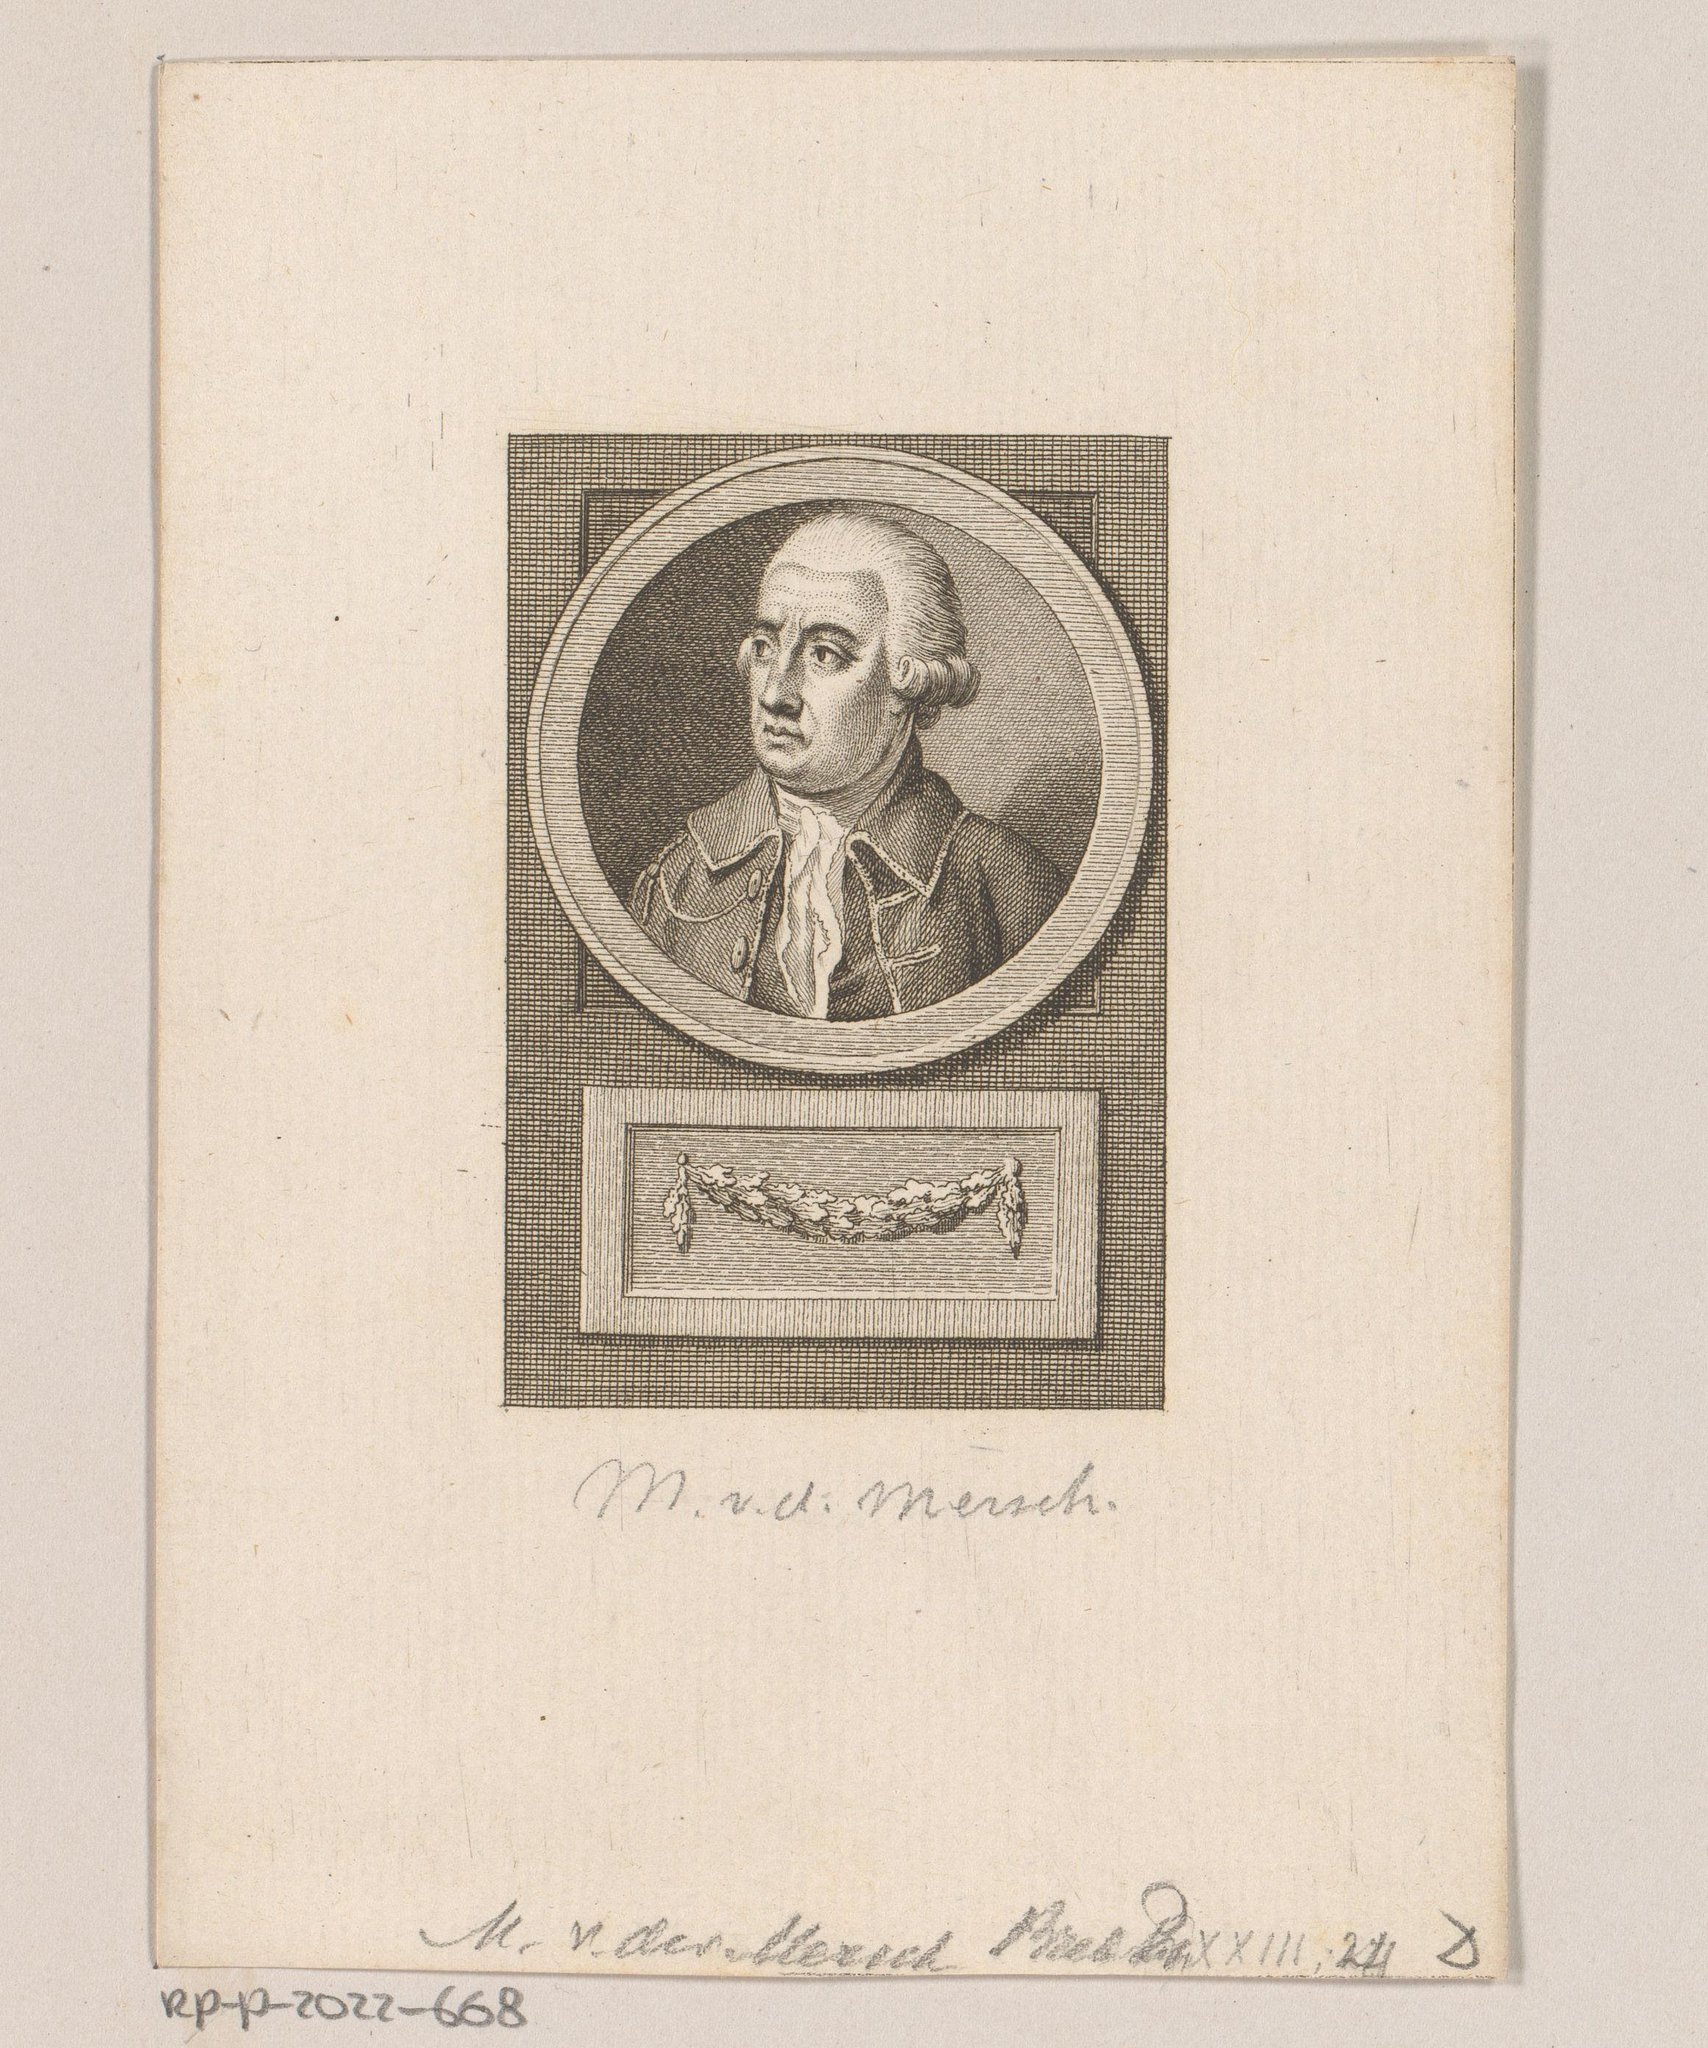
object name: print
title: Portret van Jan Andries vander Mersch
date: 1783-1795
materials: paper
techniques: engraving, etching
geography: amsterdam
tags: commander-in-chief, general, marshal, historical persons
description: Latere staat prent gebruikt in: Fokke, Jan. Geschiedenissen der Vereenigde Nederlanden voor de vaderlandsche jeugd Ie-XXVste deel. Amsterdam: Johannes Allart, 1783-1795. Deel XXIII.